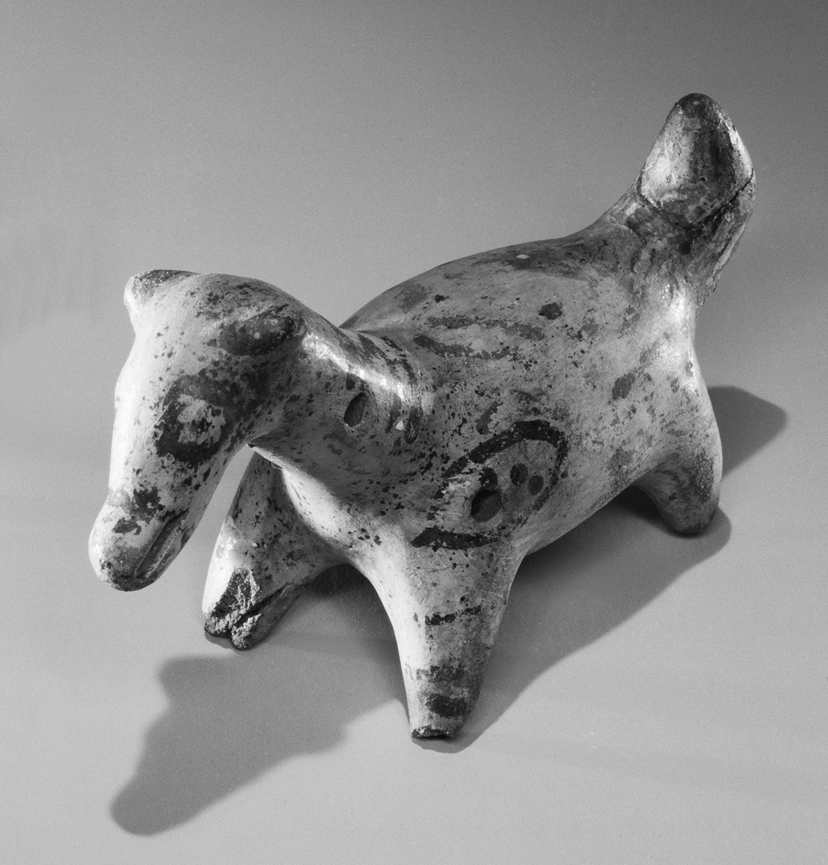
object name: pottery whistle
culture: costa rican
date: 800-1525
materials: pottery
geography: costa rica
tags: animals